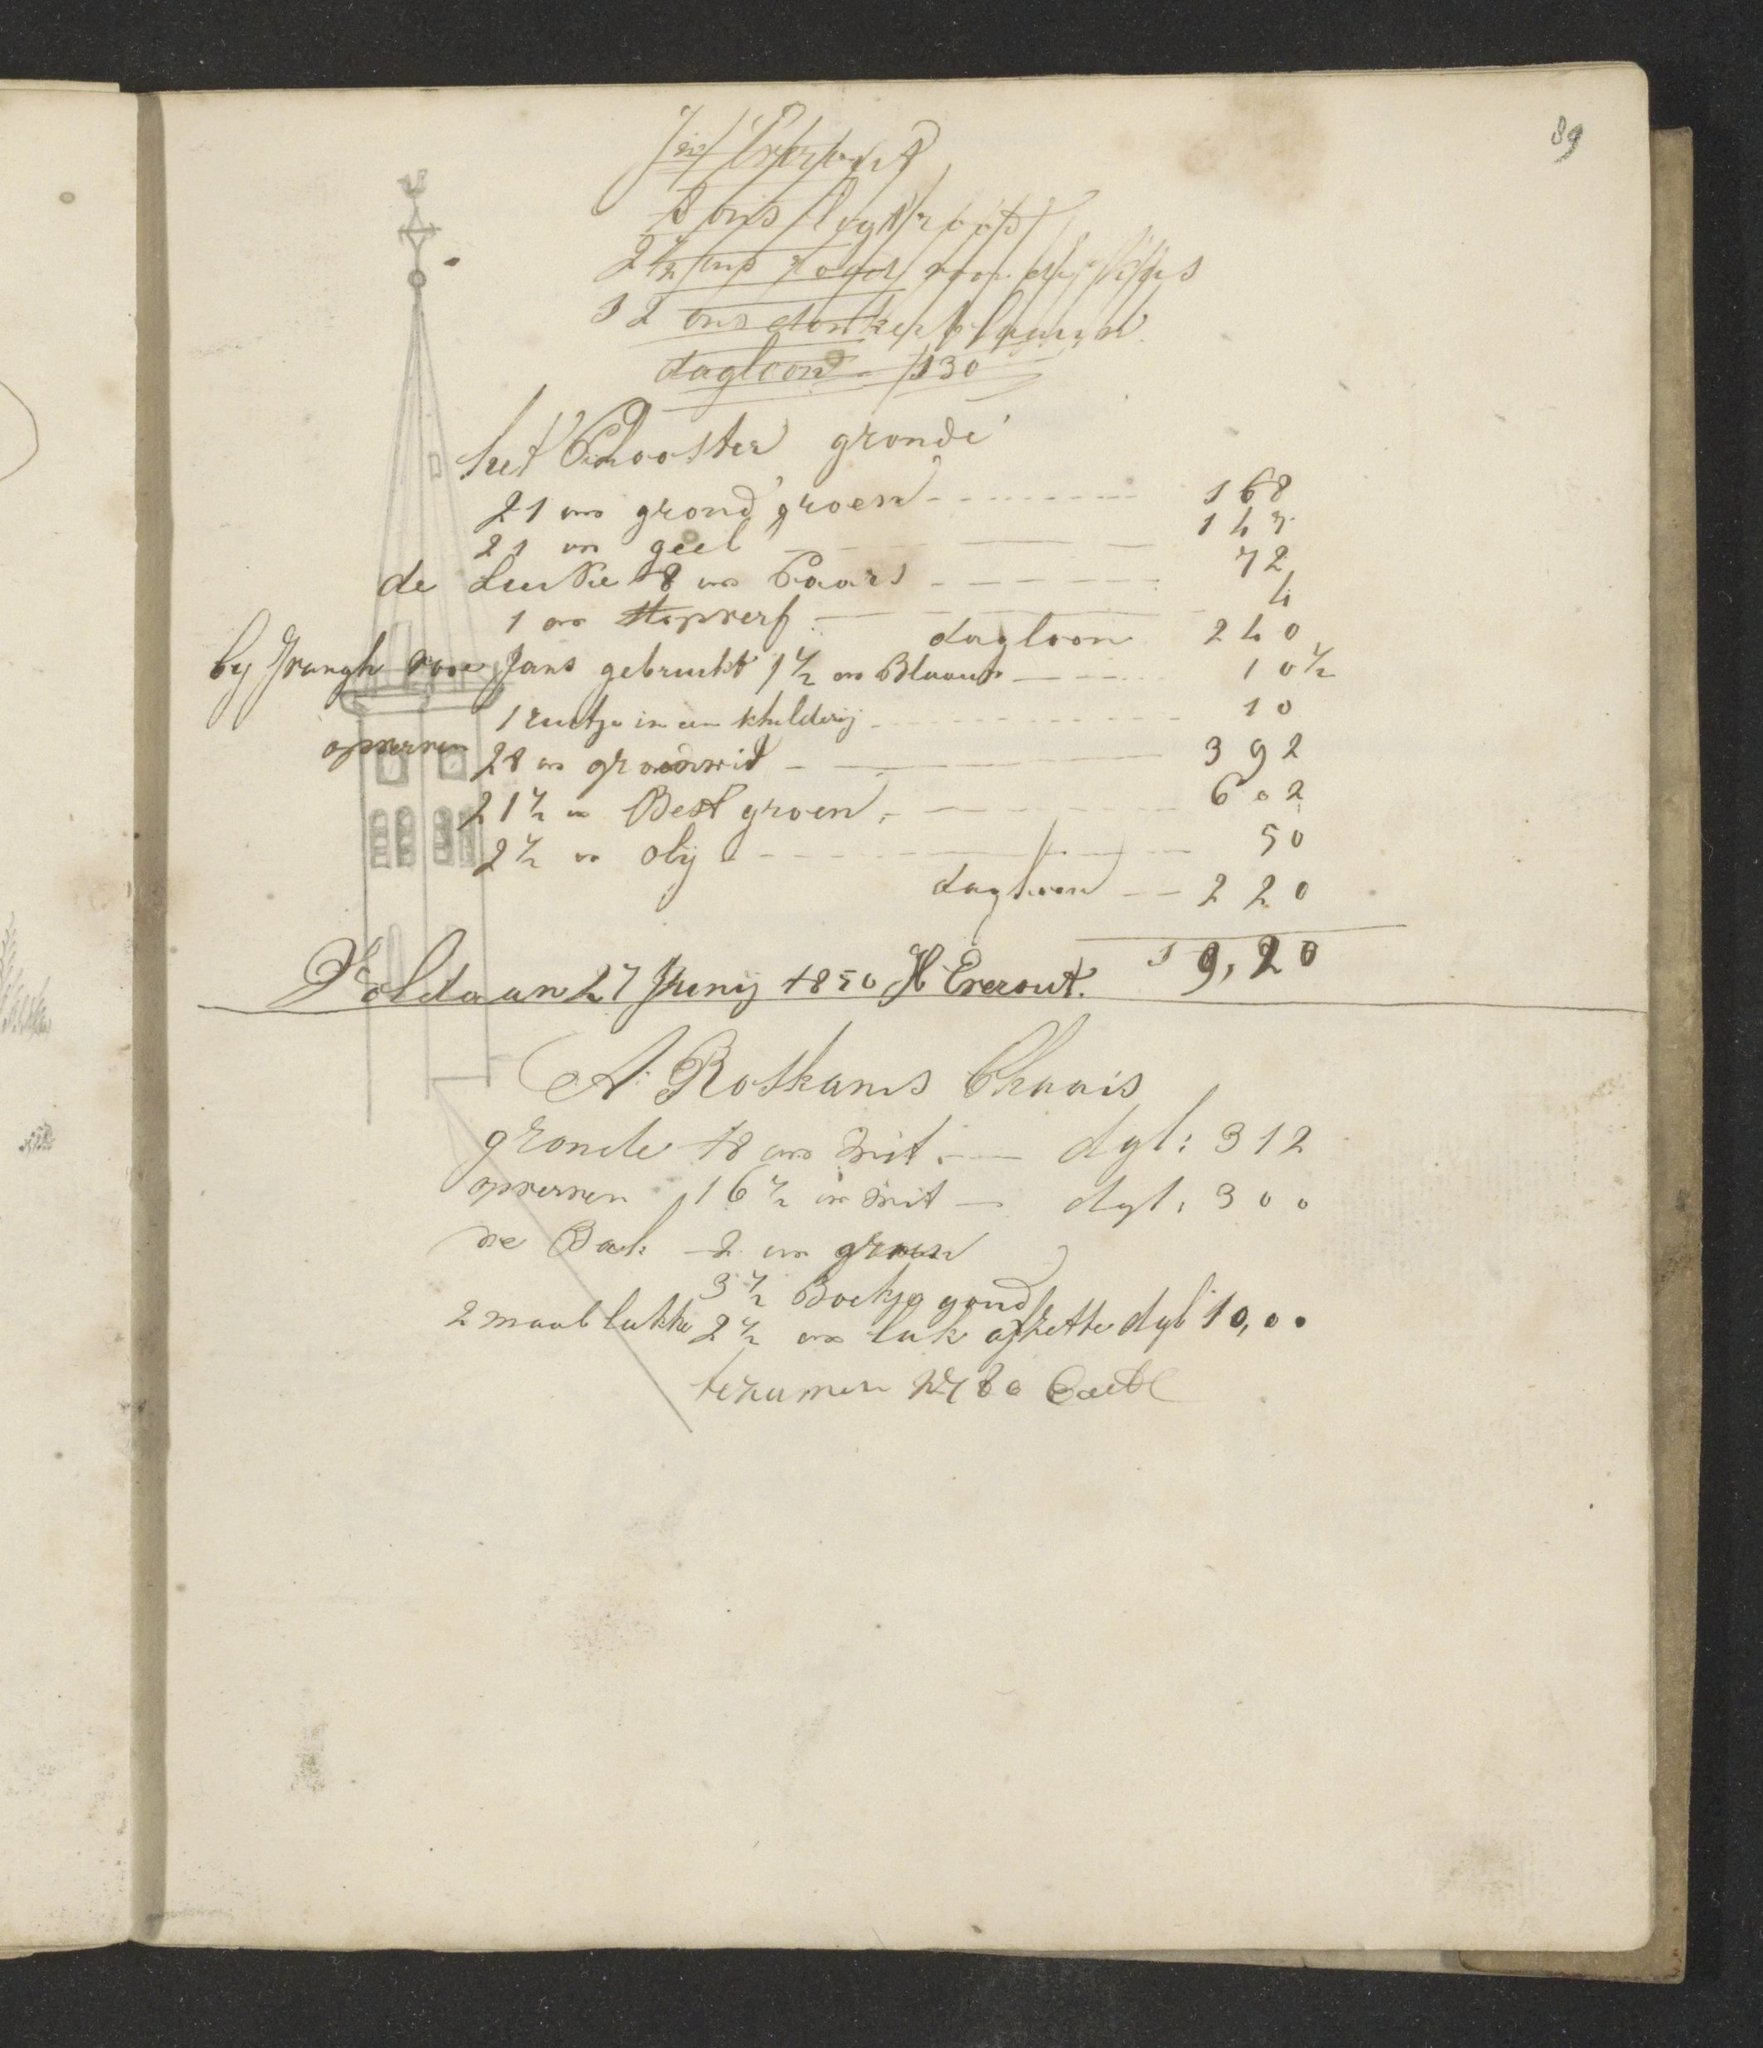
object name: sketchbook leaf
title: Kerktoren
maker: Anonymous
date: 1840-1860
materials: paper, pencil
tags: parts of church exterior and annexes: tower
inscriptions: annotation: ‘het Klooster gronde/ ...’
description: Tevens een bladzijde gebruikt als kasboek van een schilder met notities over aangeschafte materialen. Bladzijde 89 uit een schetsboek met 96 bladzijden.